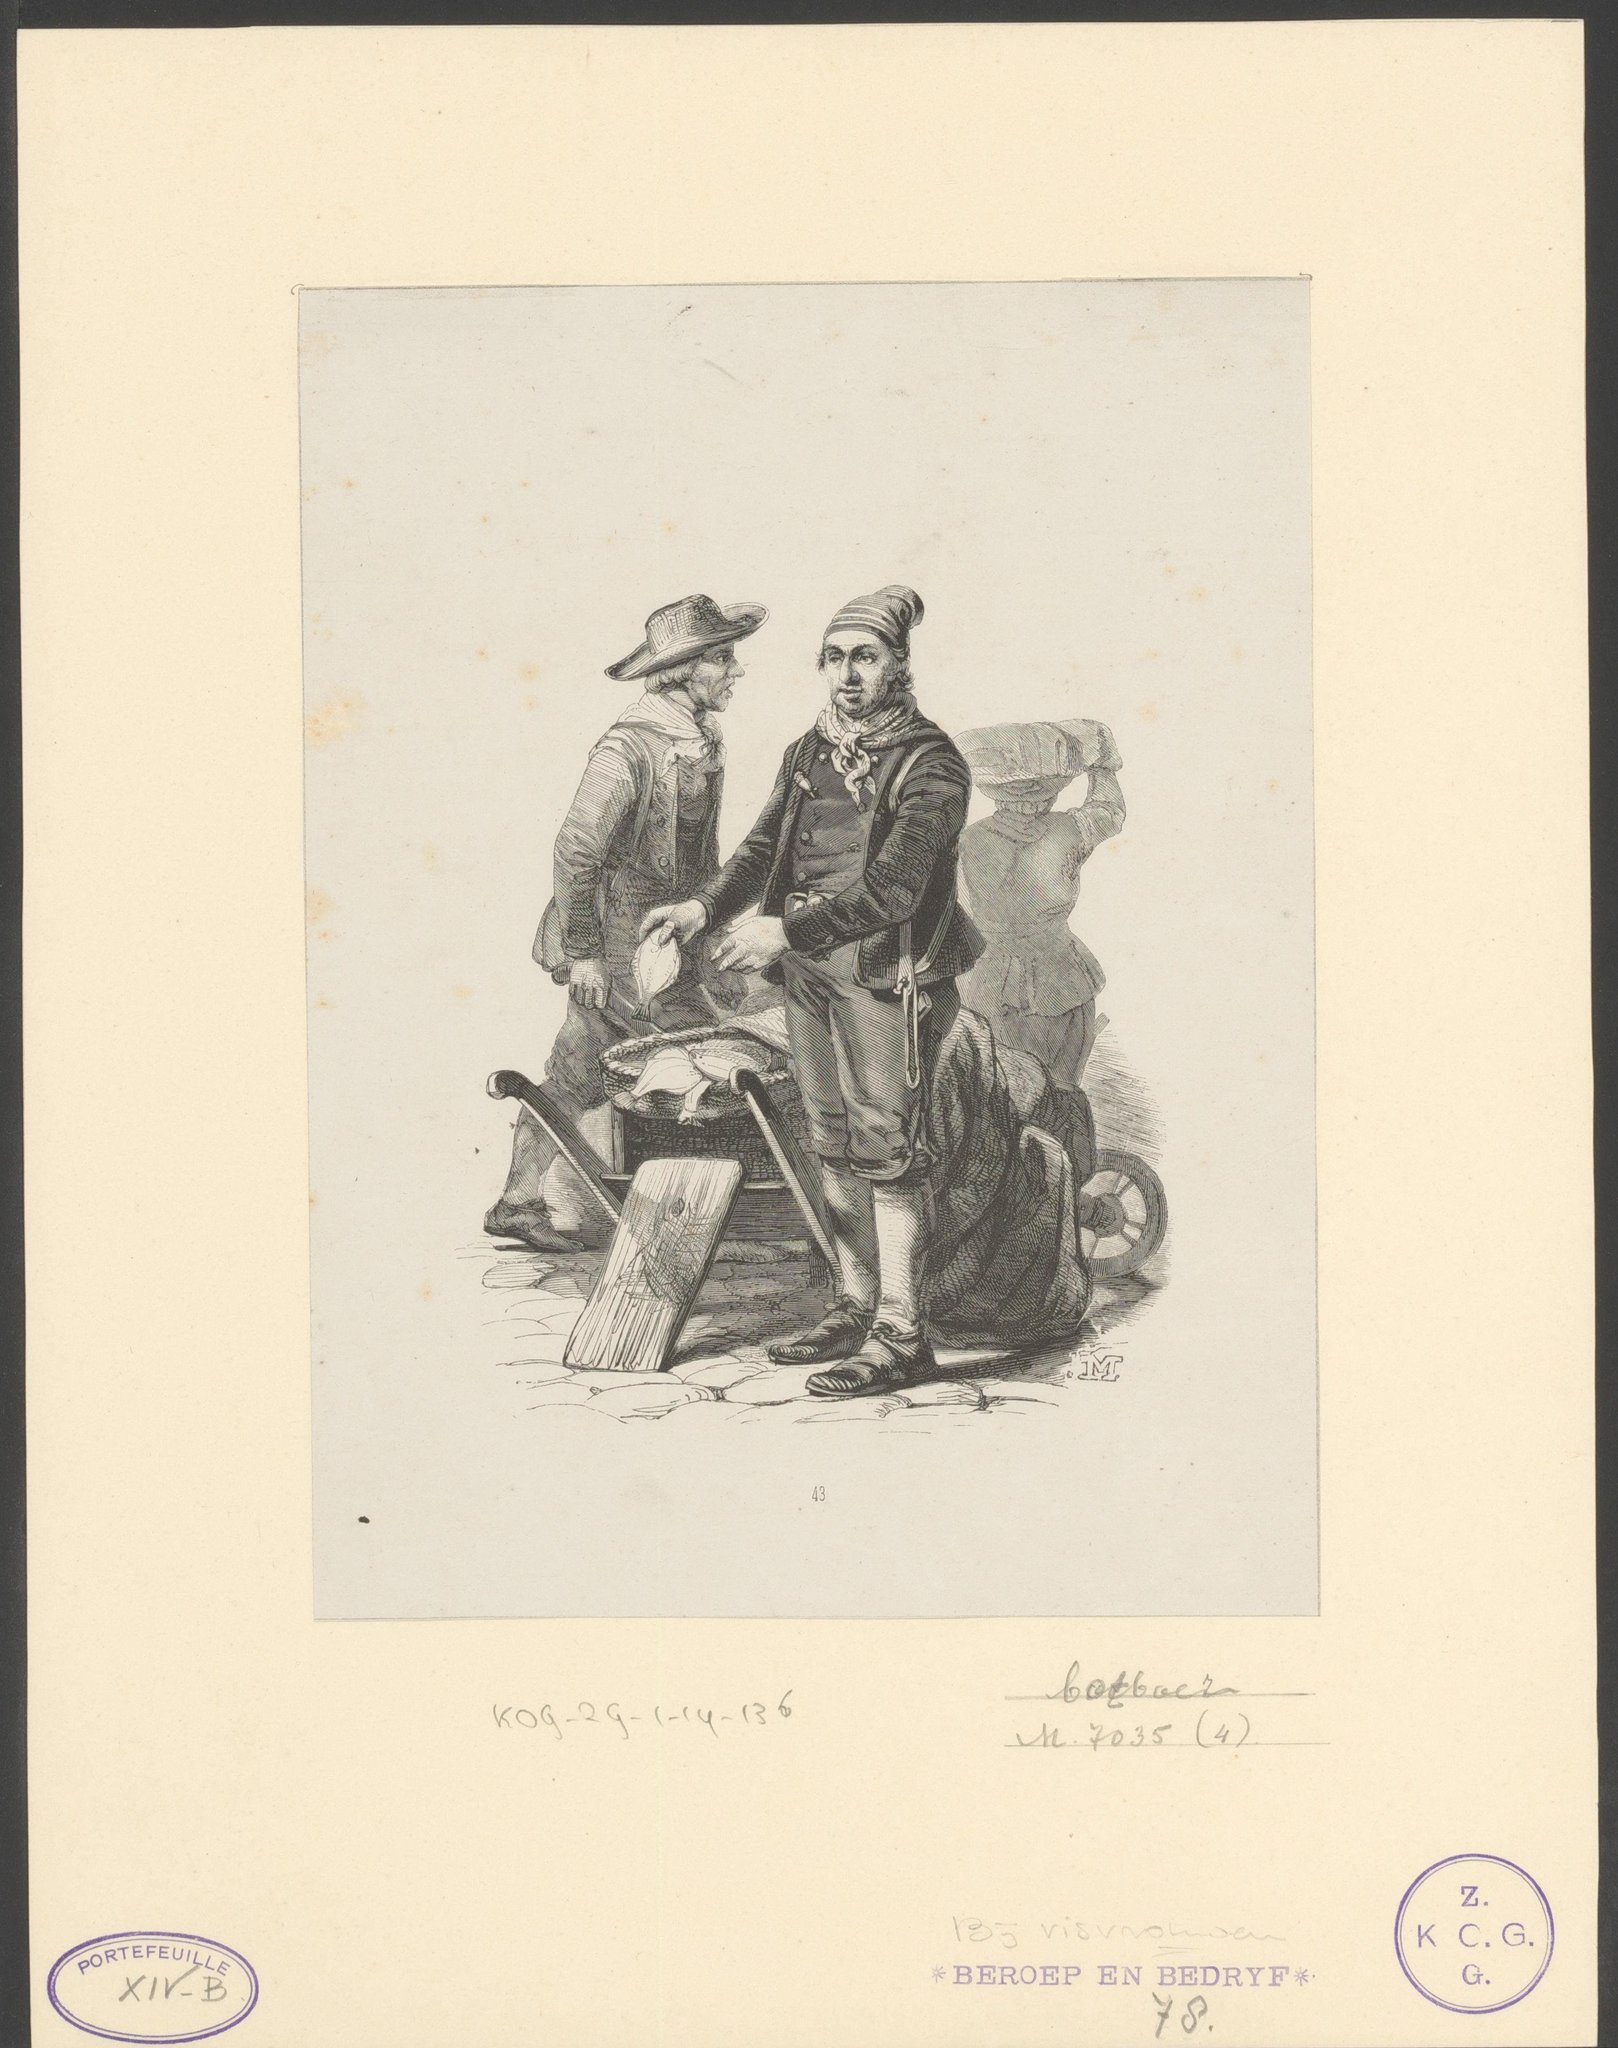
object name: print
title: Botboer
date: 1841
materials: paper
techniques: engraving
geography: netherlands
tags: merchant, salesman (fish), fishes, merchant, salesman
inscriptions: collector's mark: Lugt 1641, collector's mark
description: Illustratie gemaakt voor het boek 'De Nederlanden : karakterschetsen, kleederdrachten, houding en voorkomen van verschillende standen : tekst van de meest geachte schrijvers : met gravuren van Henry Brown naar teekeningen van de voornaamste Nederlandsche kunstenaars, Den Haag, 1841.